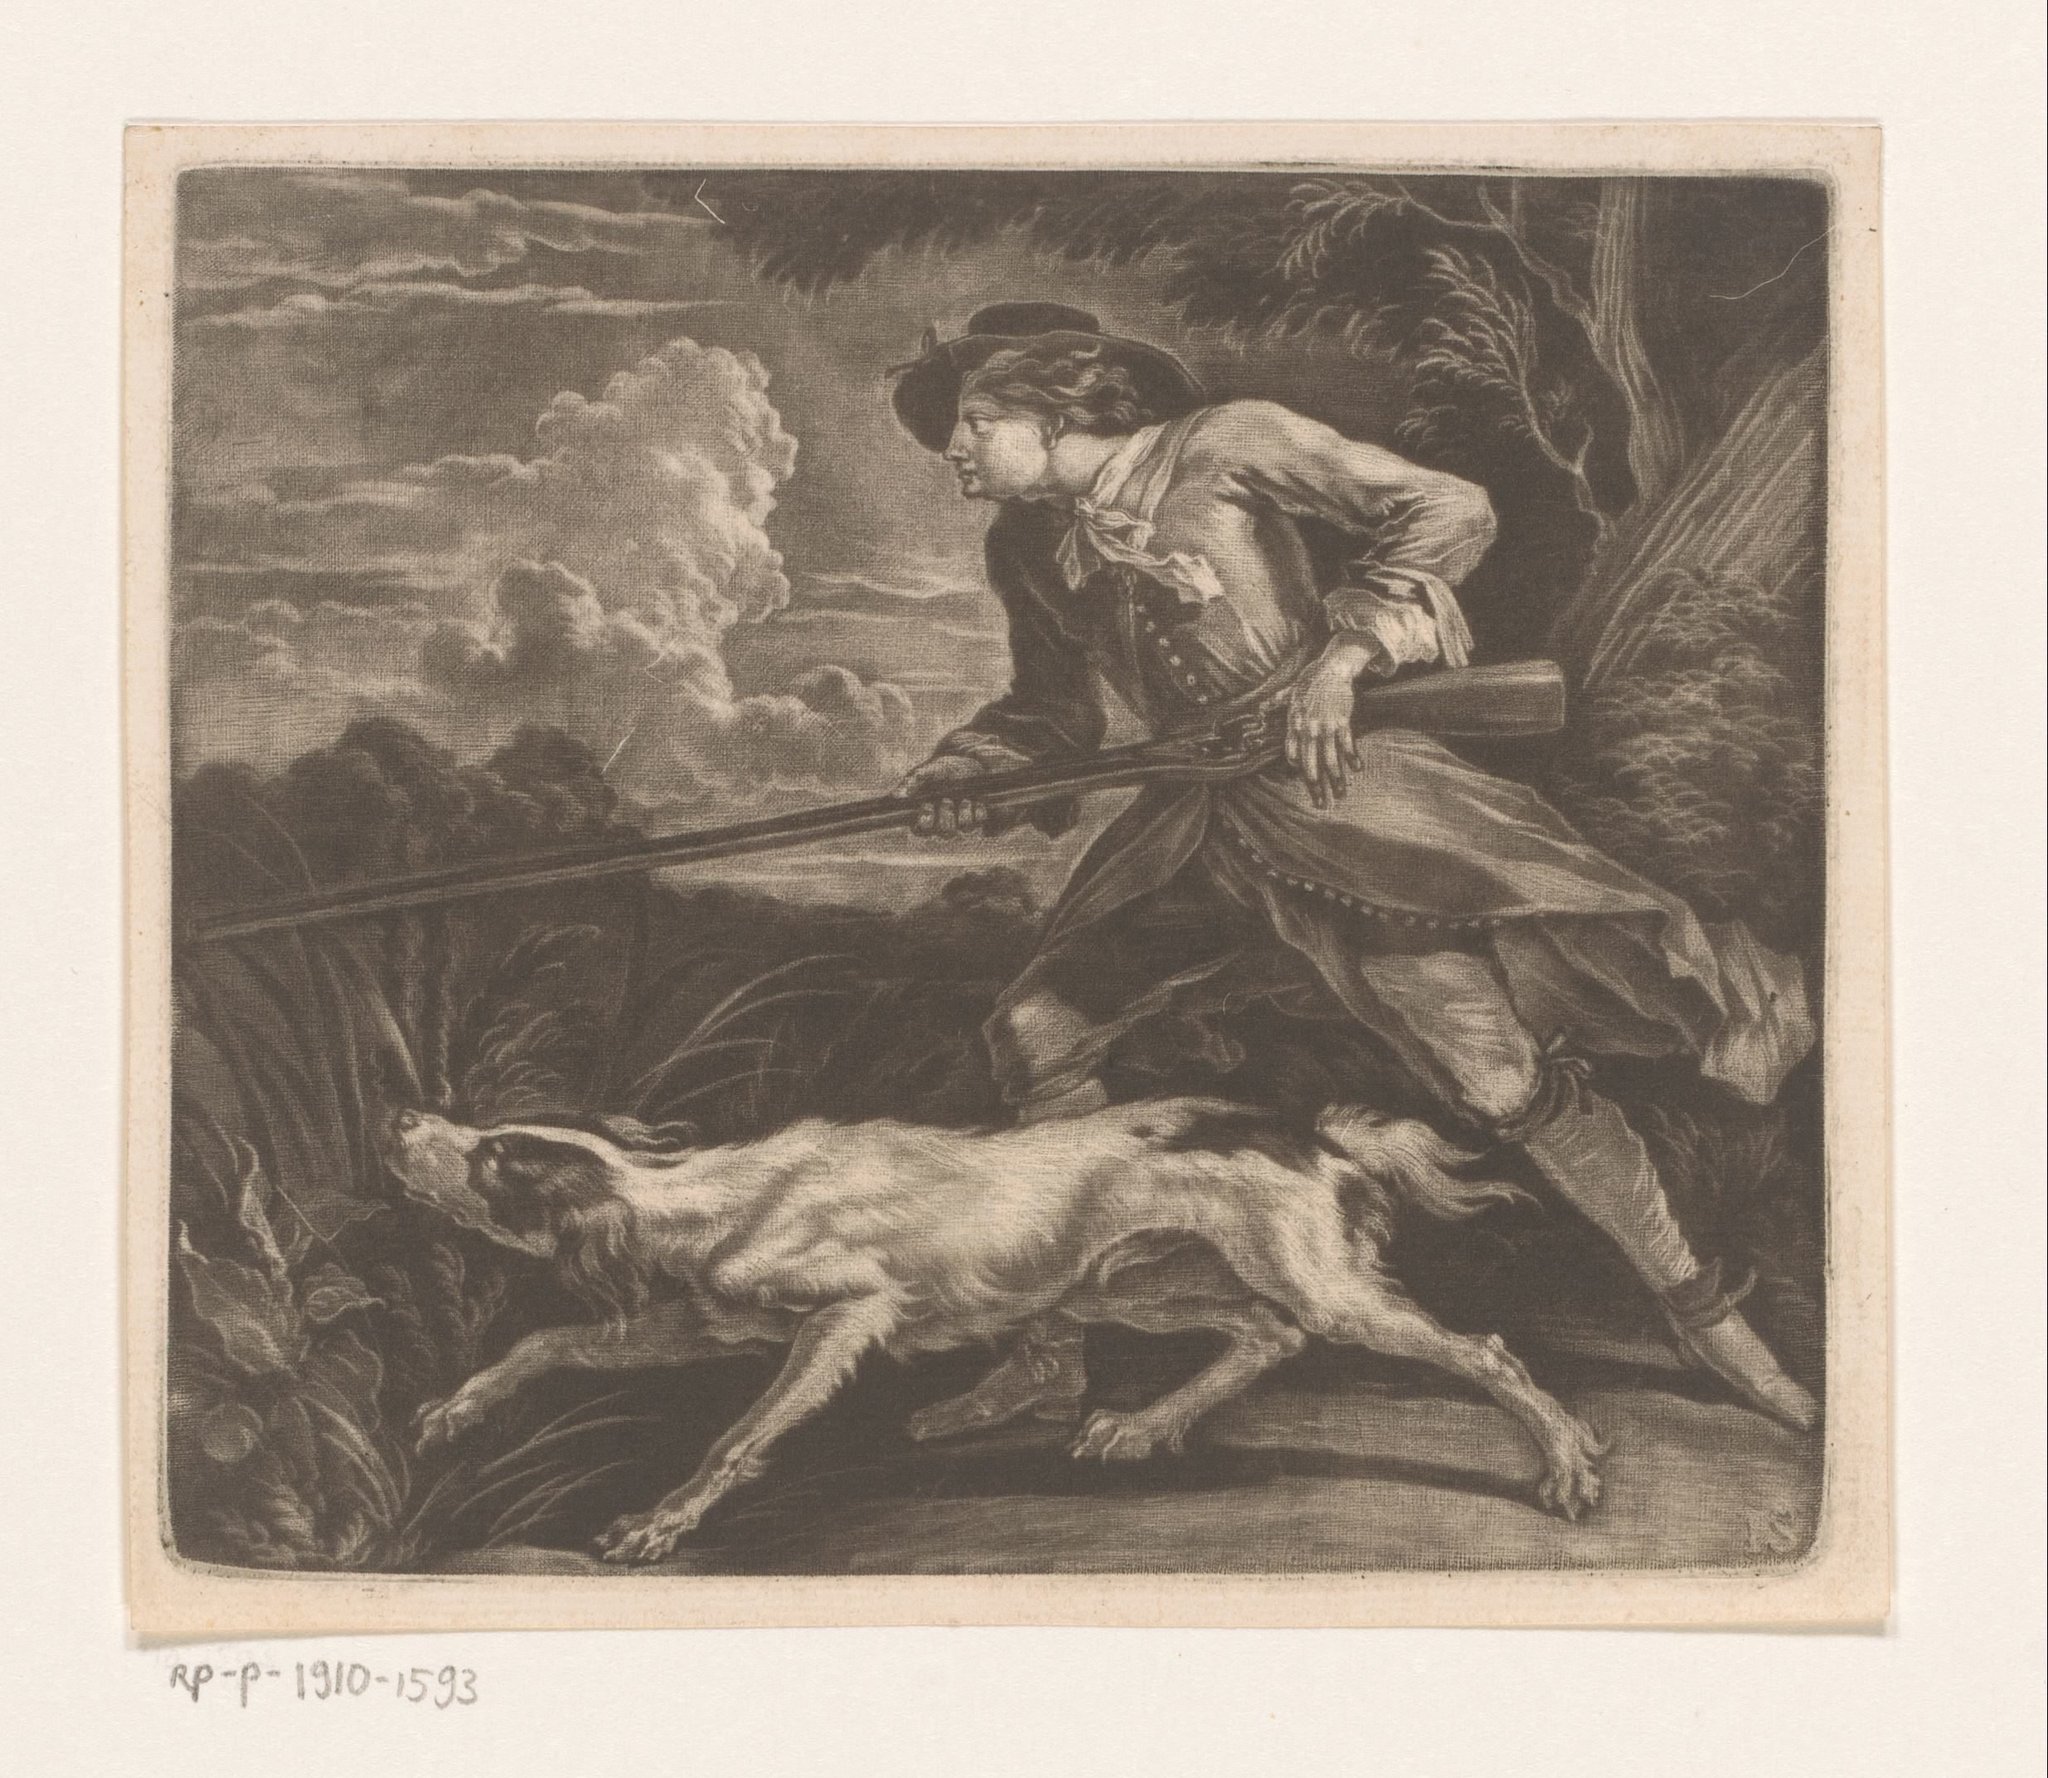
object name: print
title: Jager met zijn hond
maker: john smith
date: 1662-1742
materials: paper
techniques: mezzotint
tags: hunting dogs, hunter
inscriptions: collector's mark: Lugt 2228